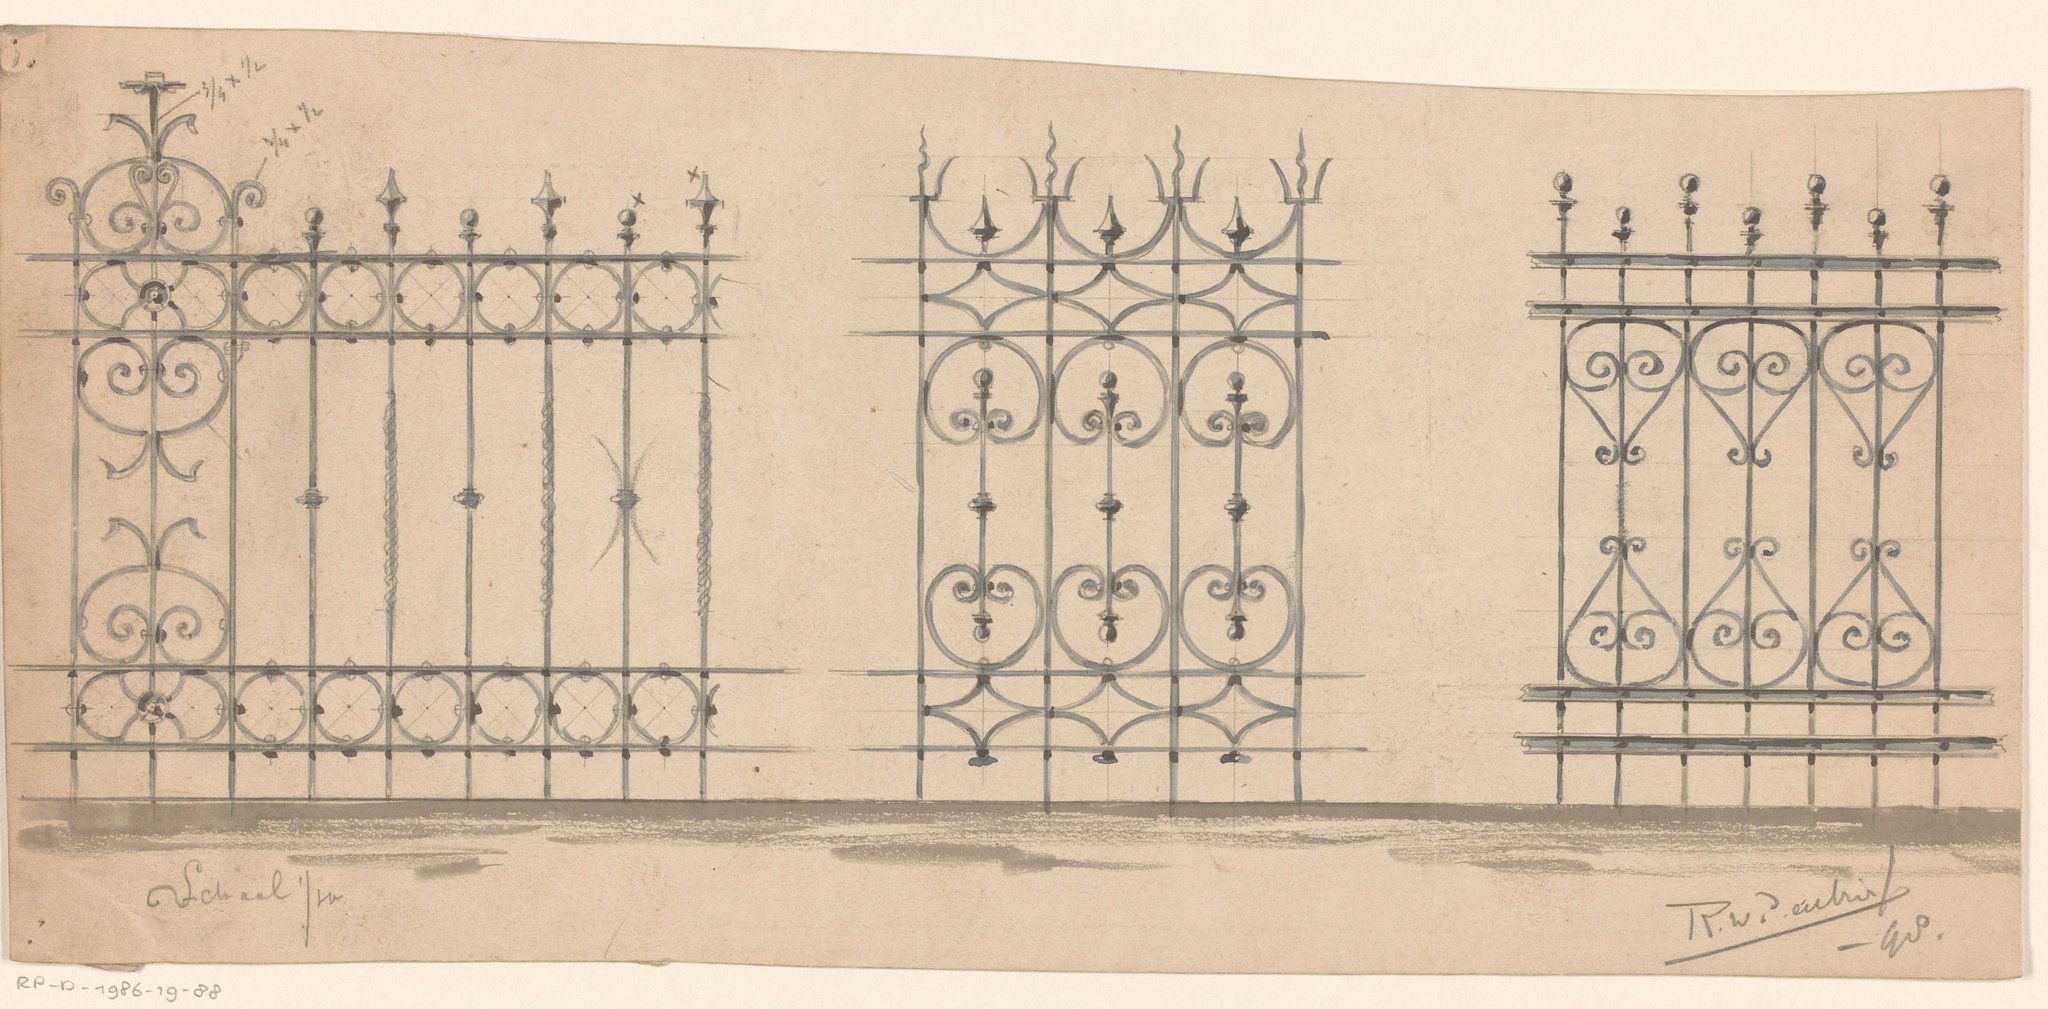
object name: design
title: Drie hekken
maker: reinier willem petrus de vries (1874-1953)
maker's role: draughtsman, print maker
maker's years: 1874-1953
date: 1898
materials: ink, paper, pencil, watercolor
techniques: brush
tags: fence, wall, paling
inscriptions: signature and date: ‘R.W P deVries/ -98.’, annotation: ‘Schaal 1/10’, collector's mark: ‘R:MVS.’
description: Ontwerpen voor drie smeedijzeren hekken met ornamenten.